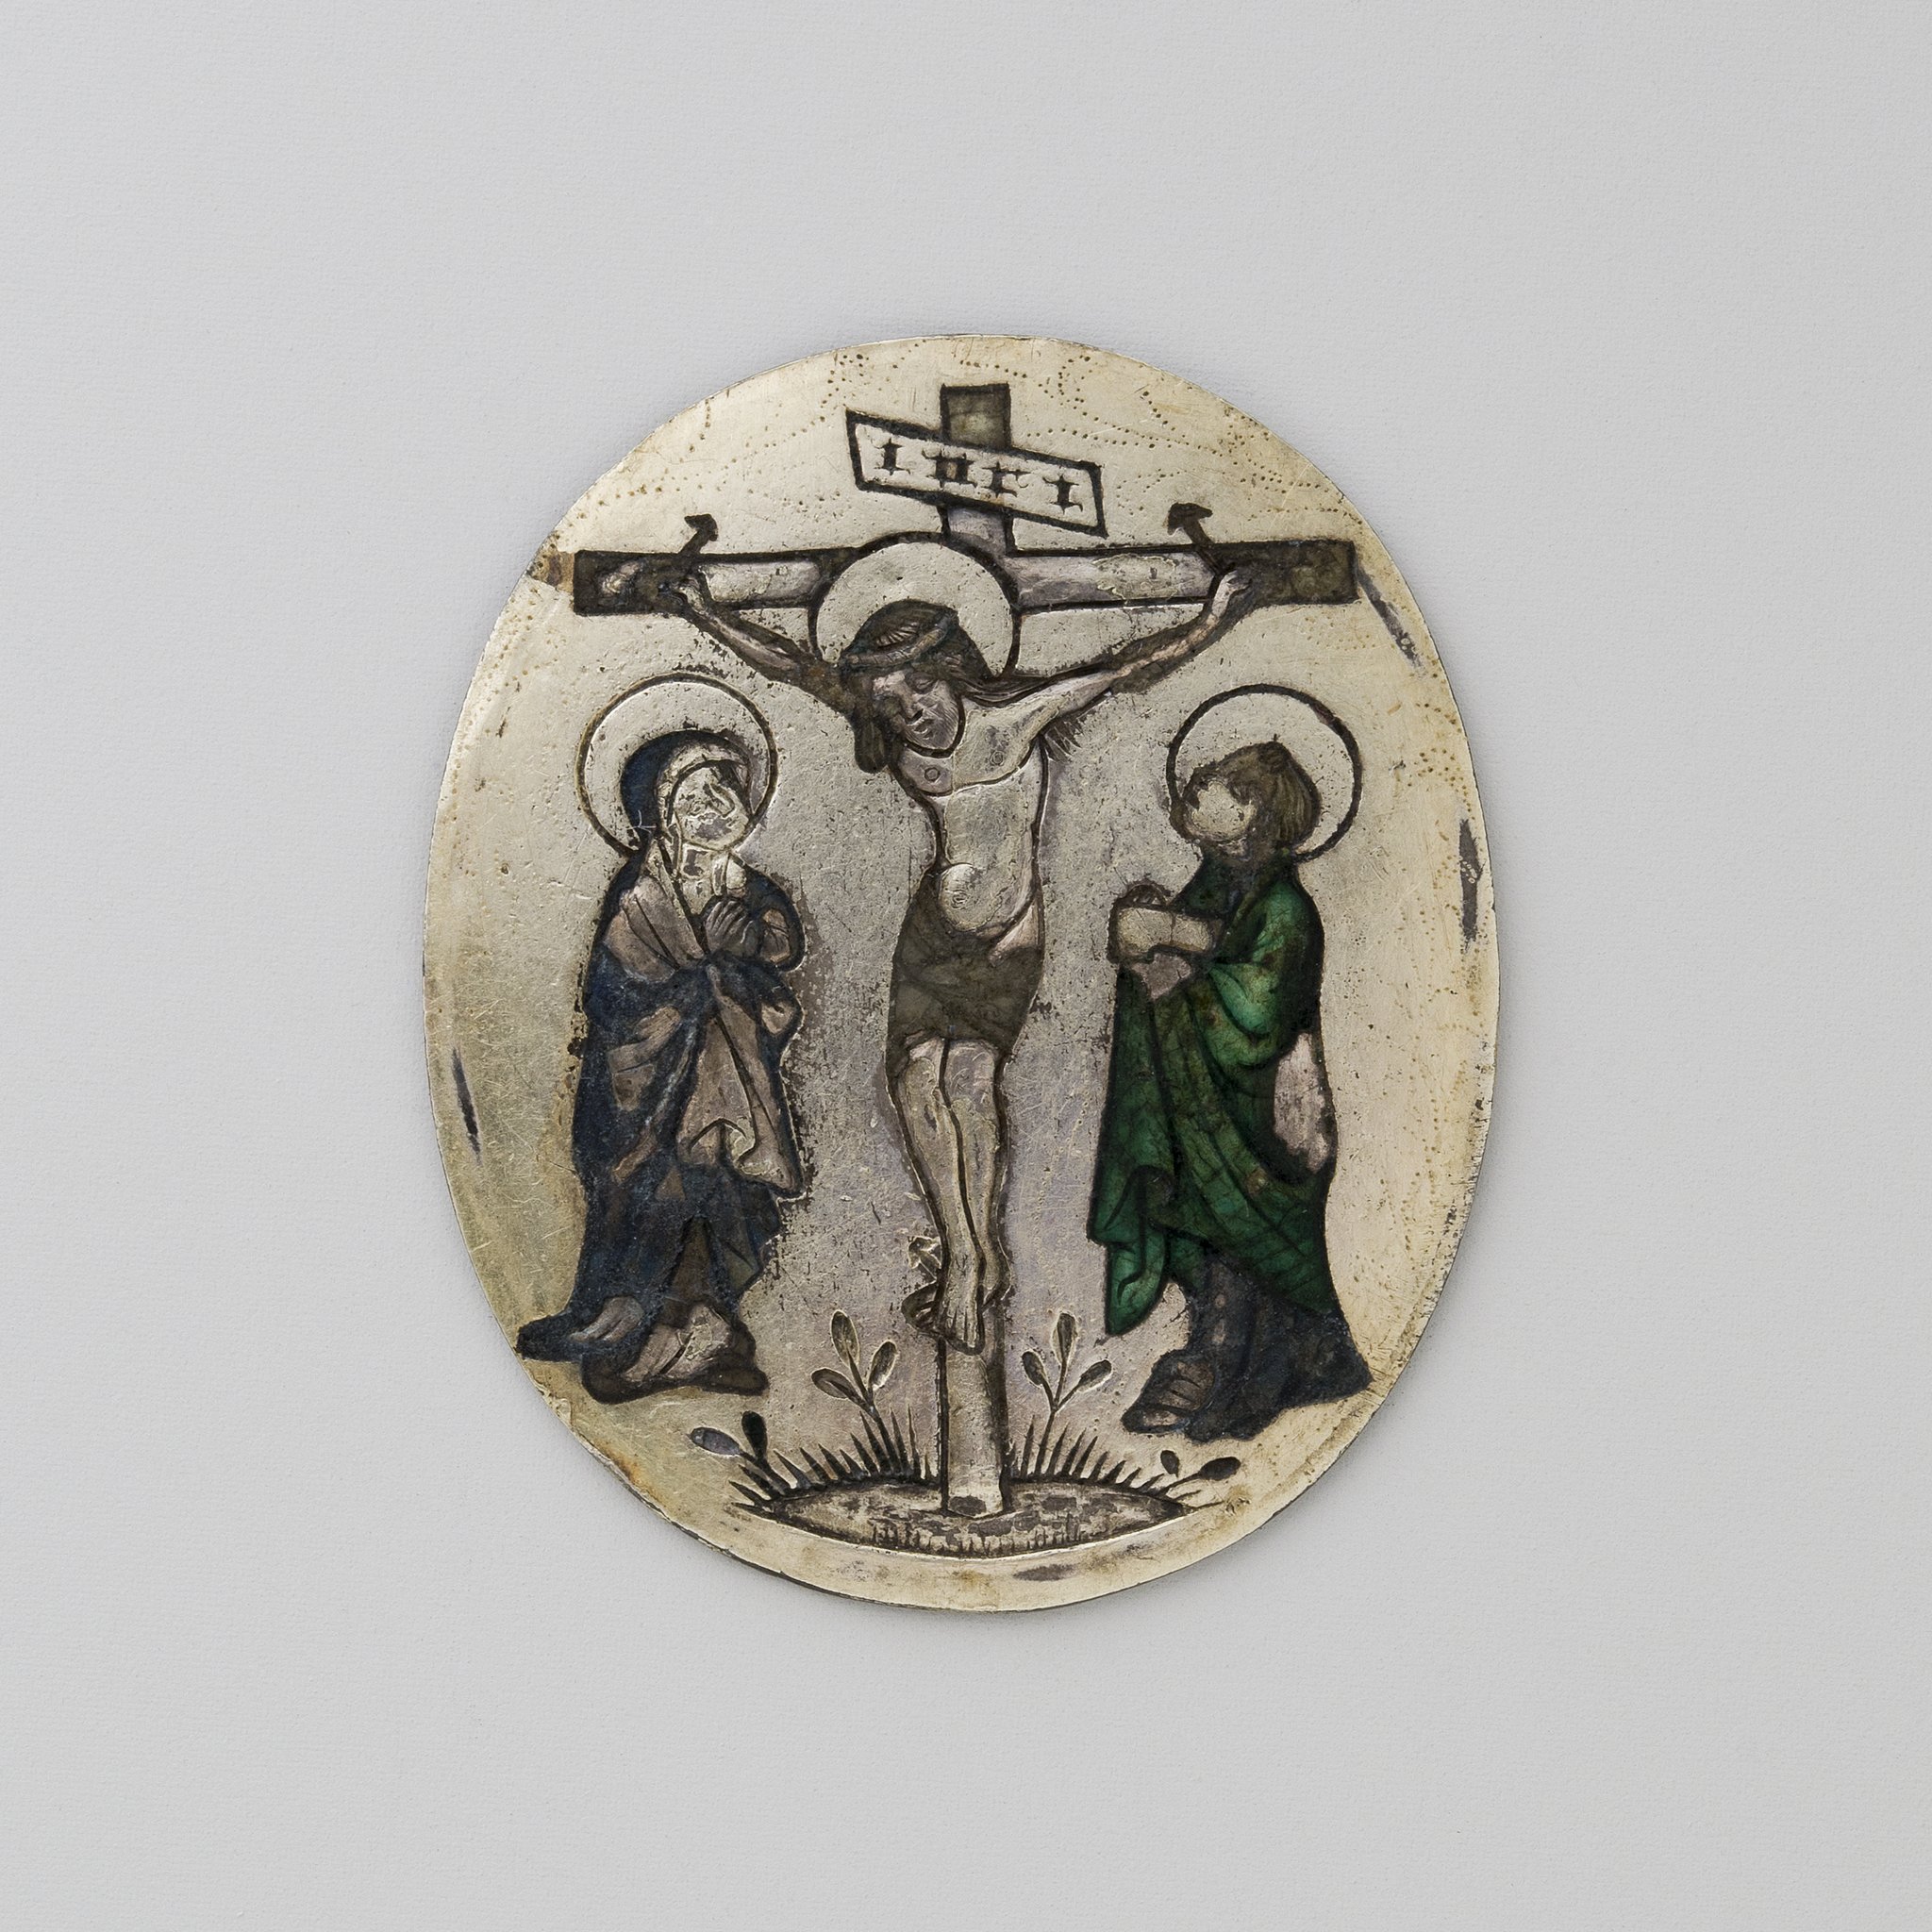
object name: plaque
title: Enamel Plaque with the Crucifixion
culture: south netherlandish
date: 1440-1460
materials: enamel, silver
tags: christ,cross